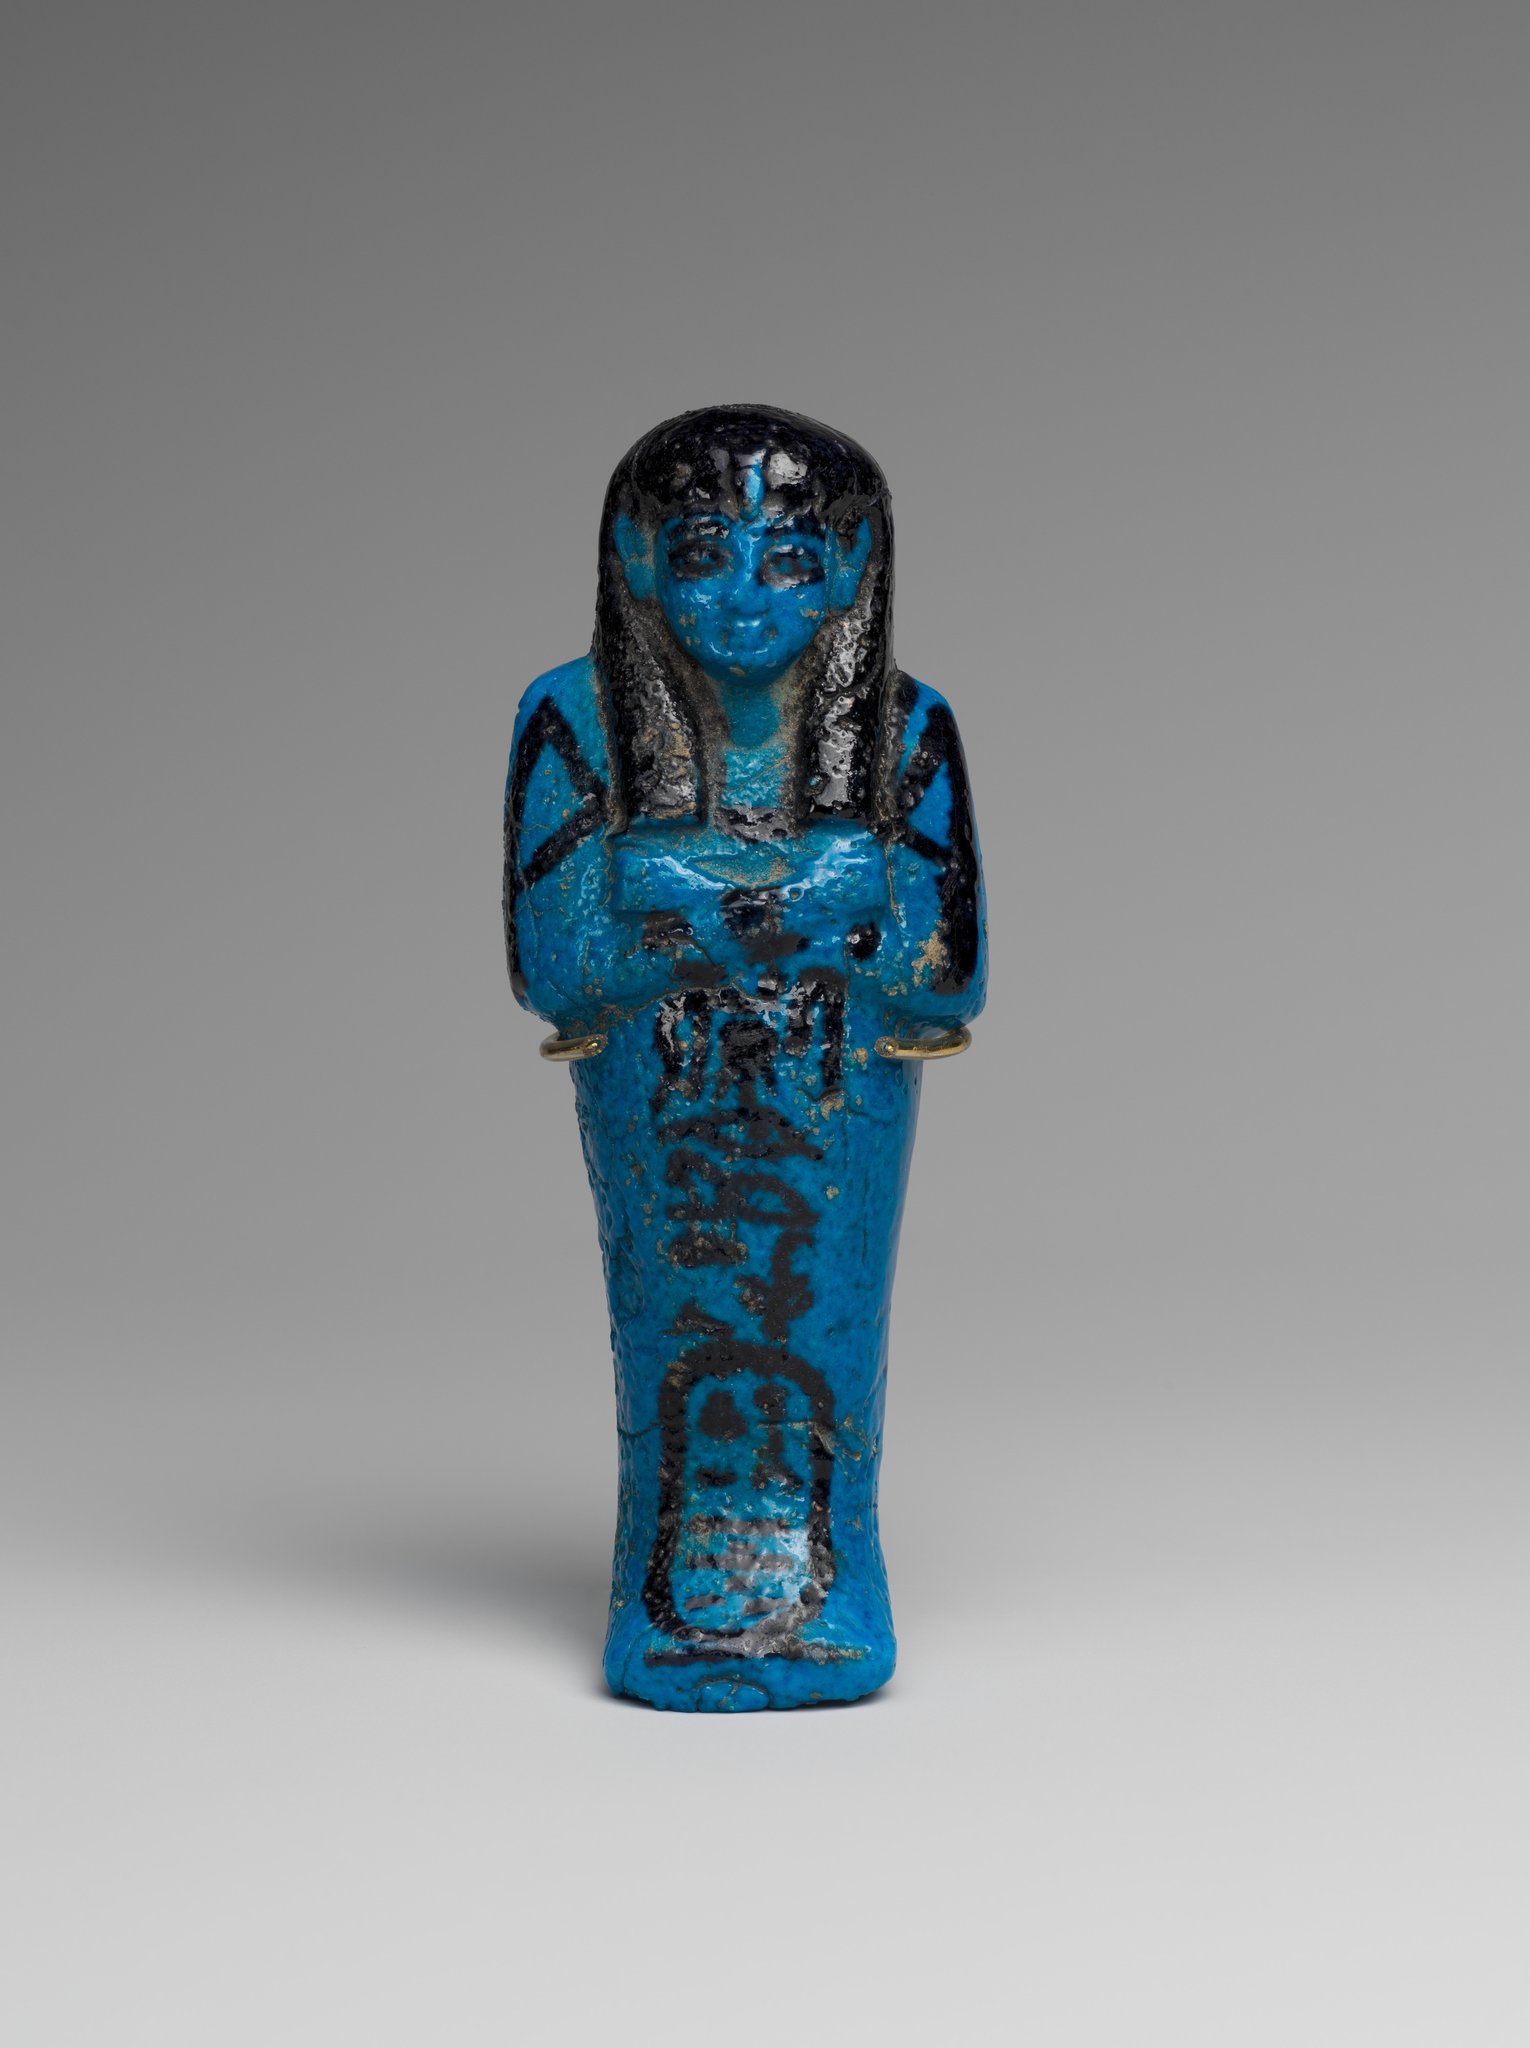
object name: shabti, queen henettawy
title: Shabti of the Adoratrice of Hathor ("Duahathor") Henettawy, wife of Painedjem I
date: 1064-1055 BCE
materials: faience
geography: upper egypt, thebes